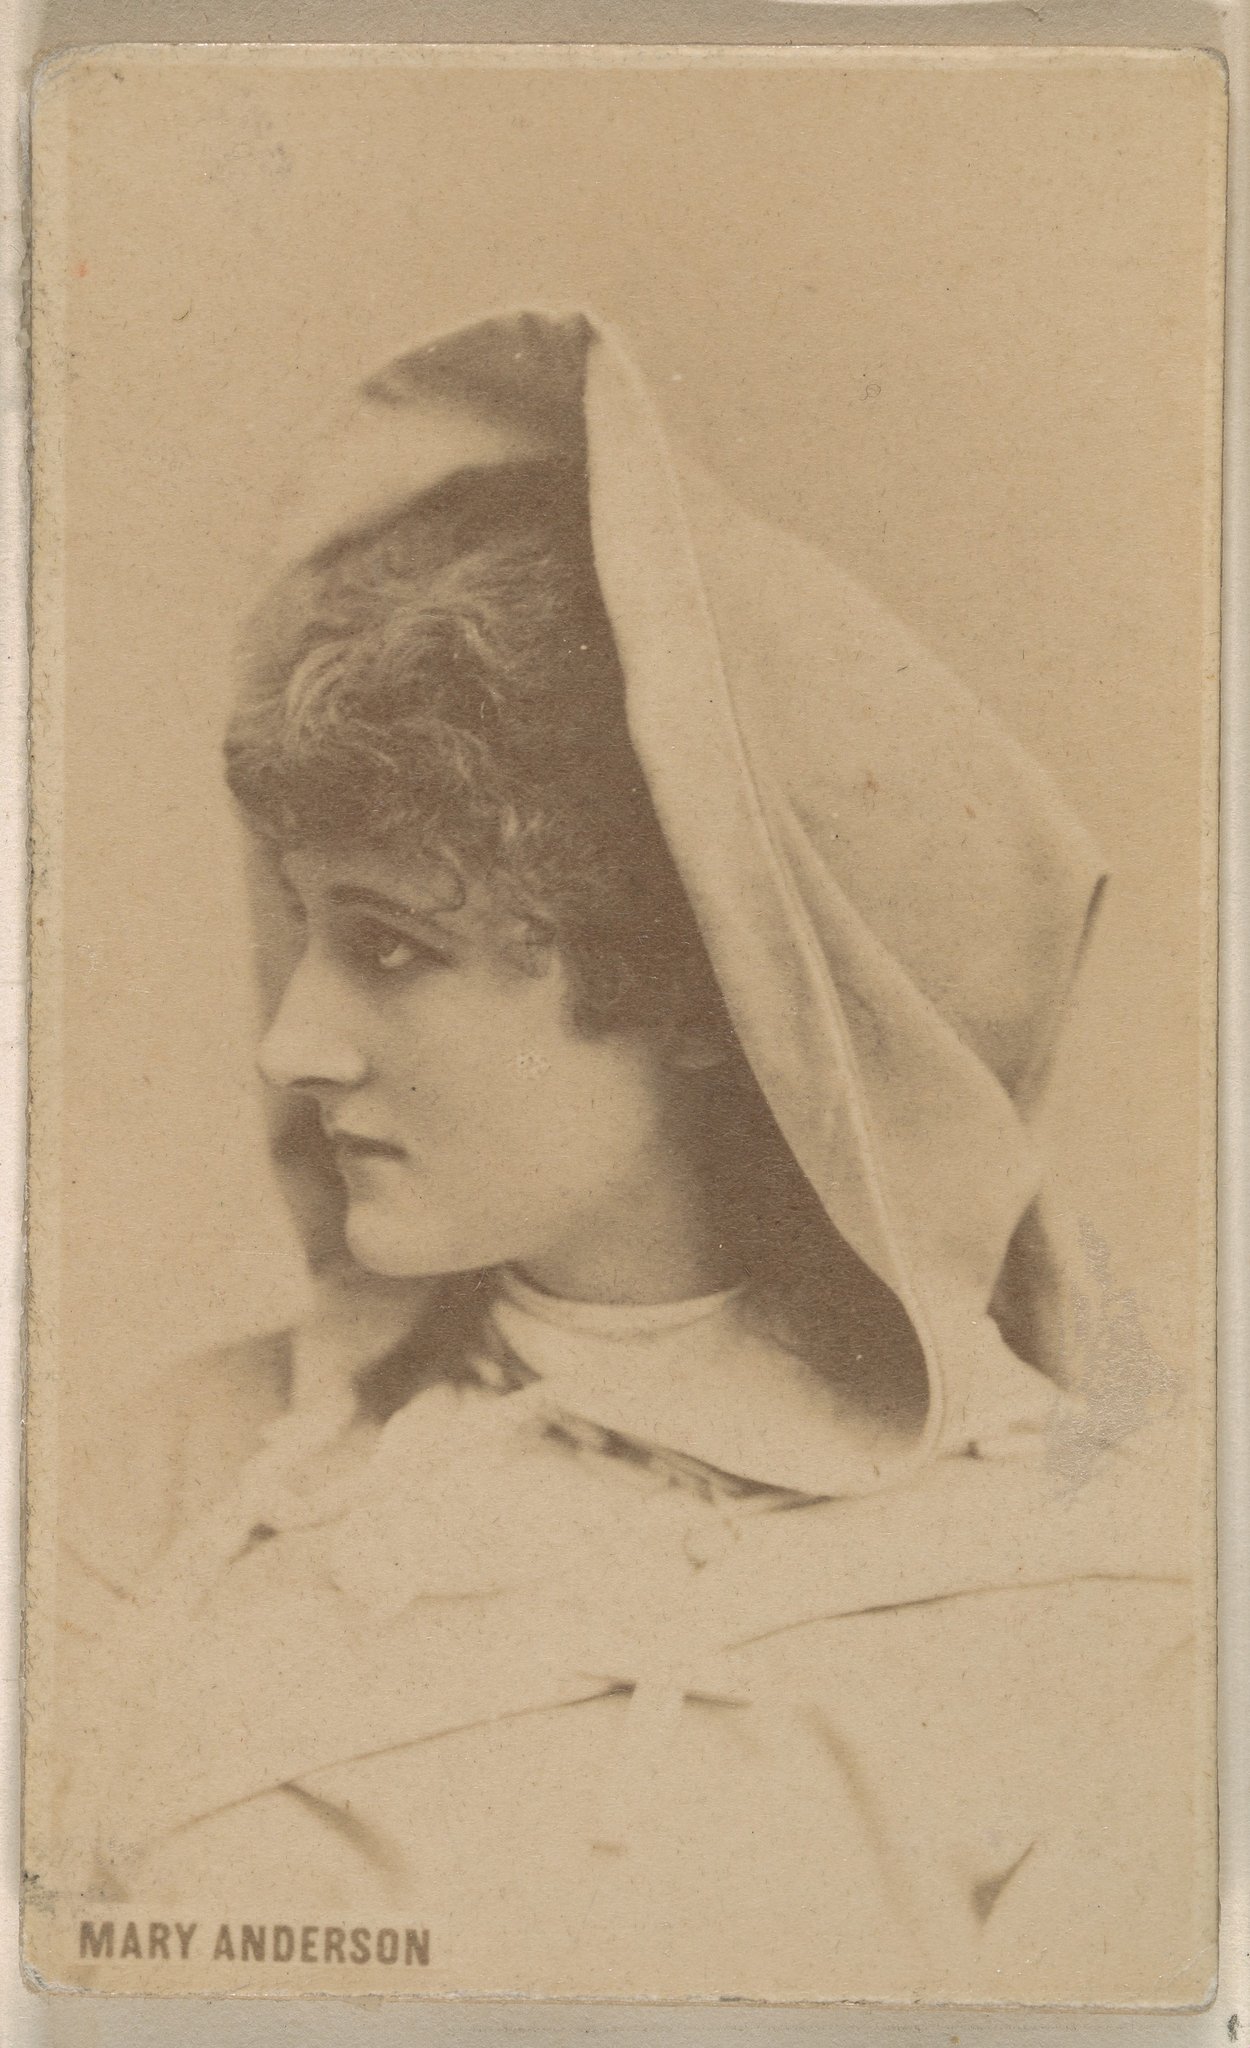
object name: photograph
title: Mary Anderson, from the Actresses series (N246), Type 1, issued by Kinney Brothers to promote Sporting Extra Cigarettes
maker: kinney brothers tobacco company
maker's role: publisher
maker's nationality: american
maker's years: 1869-2011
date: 1890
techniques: albumen silver print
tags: women,actresses